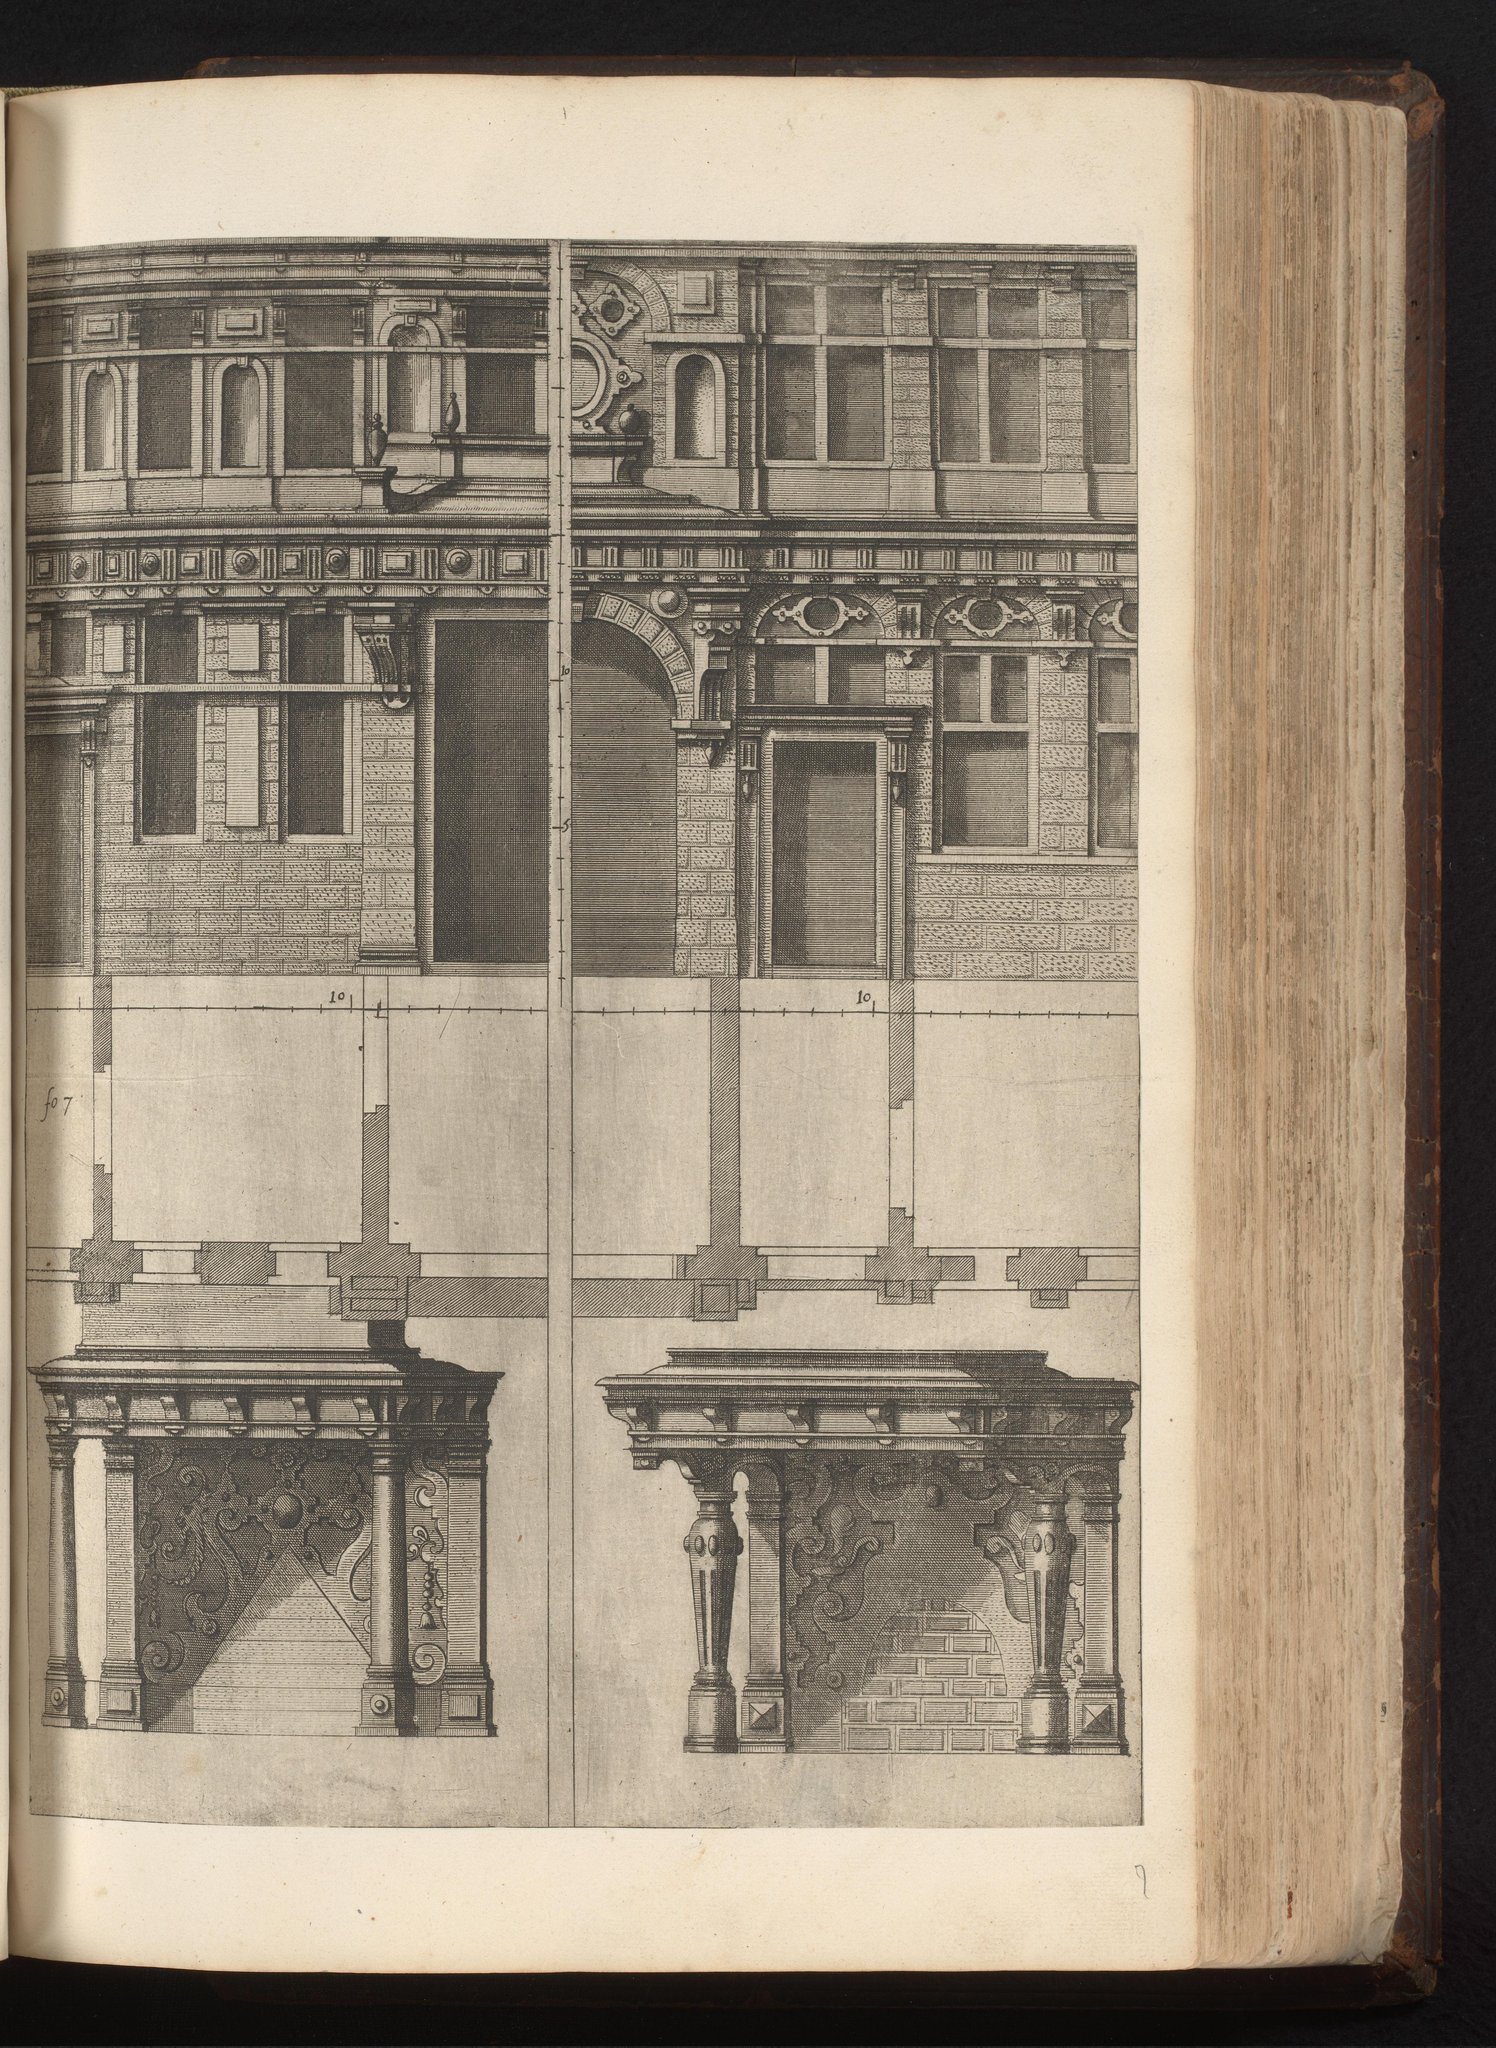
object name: album leaf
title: Gevels en haarden in de Dorische orde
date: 1581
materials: paper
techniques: engraving, etching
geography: antwerp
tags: doric order ~ architecture, open hearth, fire-place, civic architecture; edifices; dwellings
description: Prent uit: Vredeman de Vries, Hans. Architectura oder Bauung der Antiquen auss dem Vitruvius, waellches sein funff Collummen orden, (...). Antwerpen: Gerard de Jode en Gerard Smits, 1581. Prent eerder verschenen in de 1577-editie.